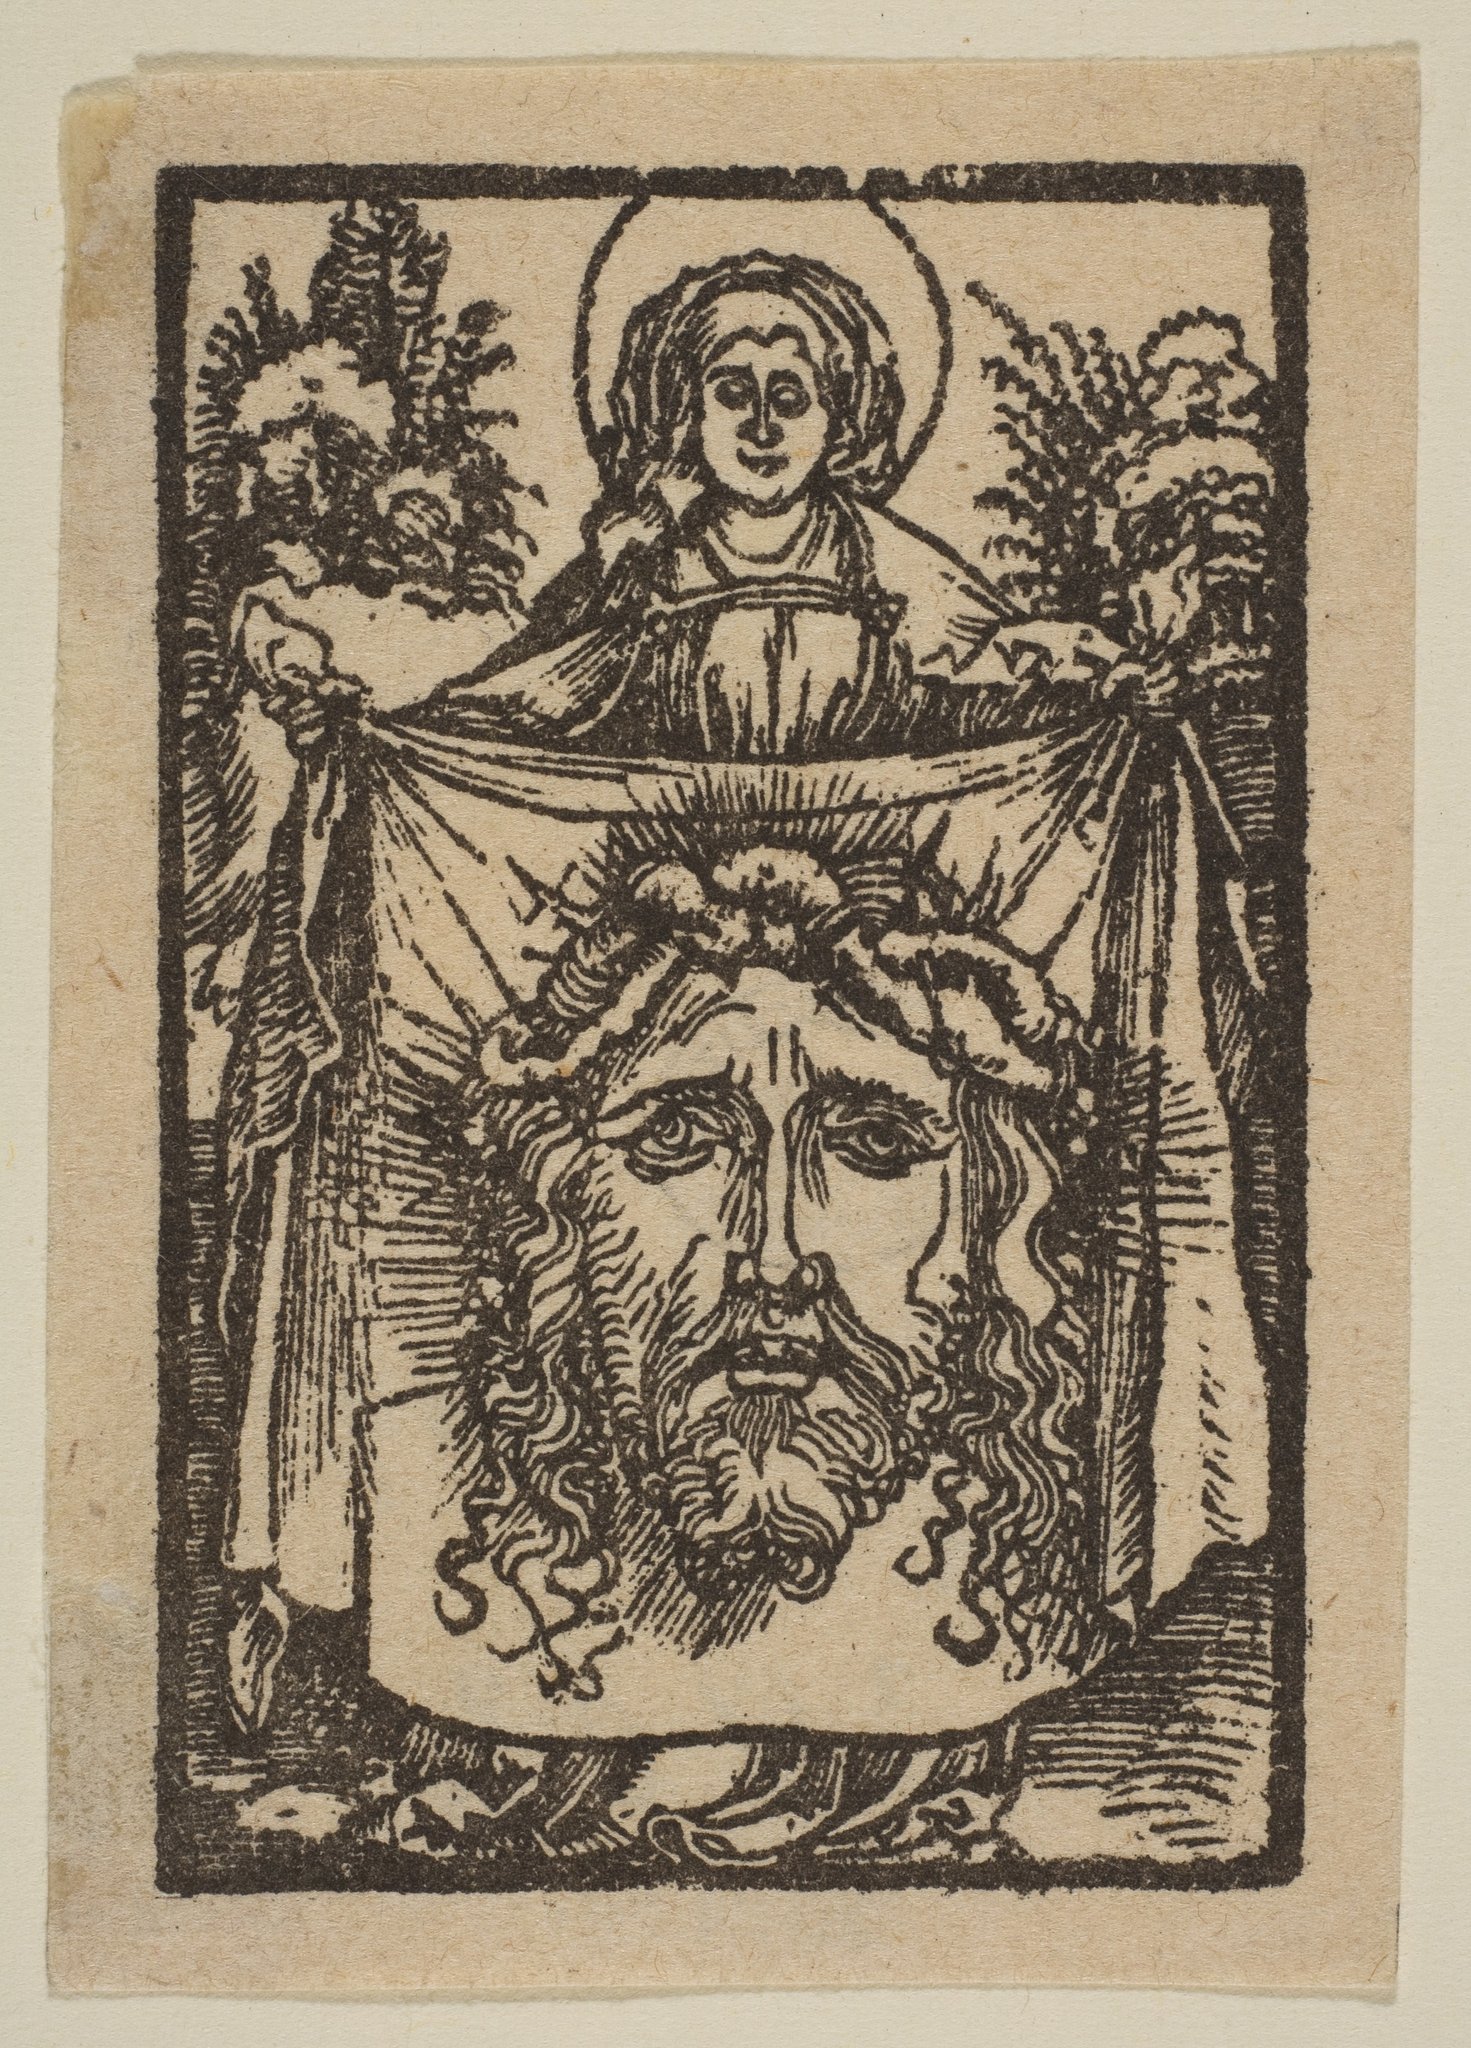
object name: print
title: Saint Veronica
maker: albrecht dürer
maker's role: artist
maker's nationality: german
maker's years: 1471-1528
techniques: woodcut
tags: women,christ,saints